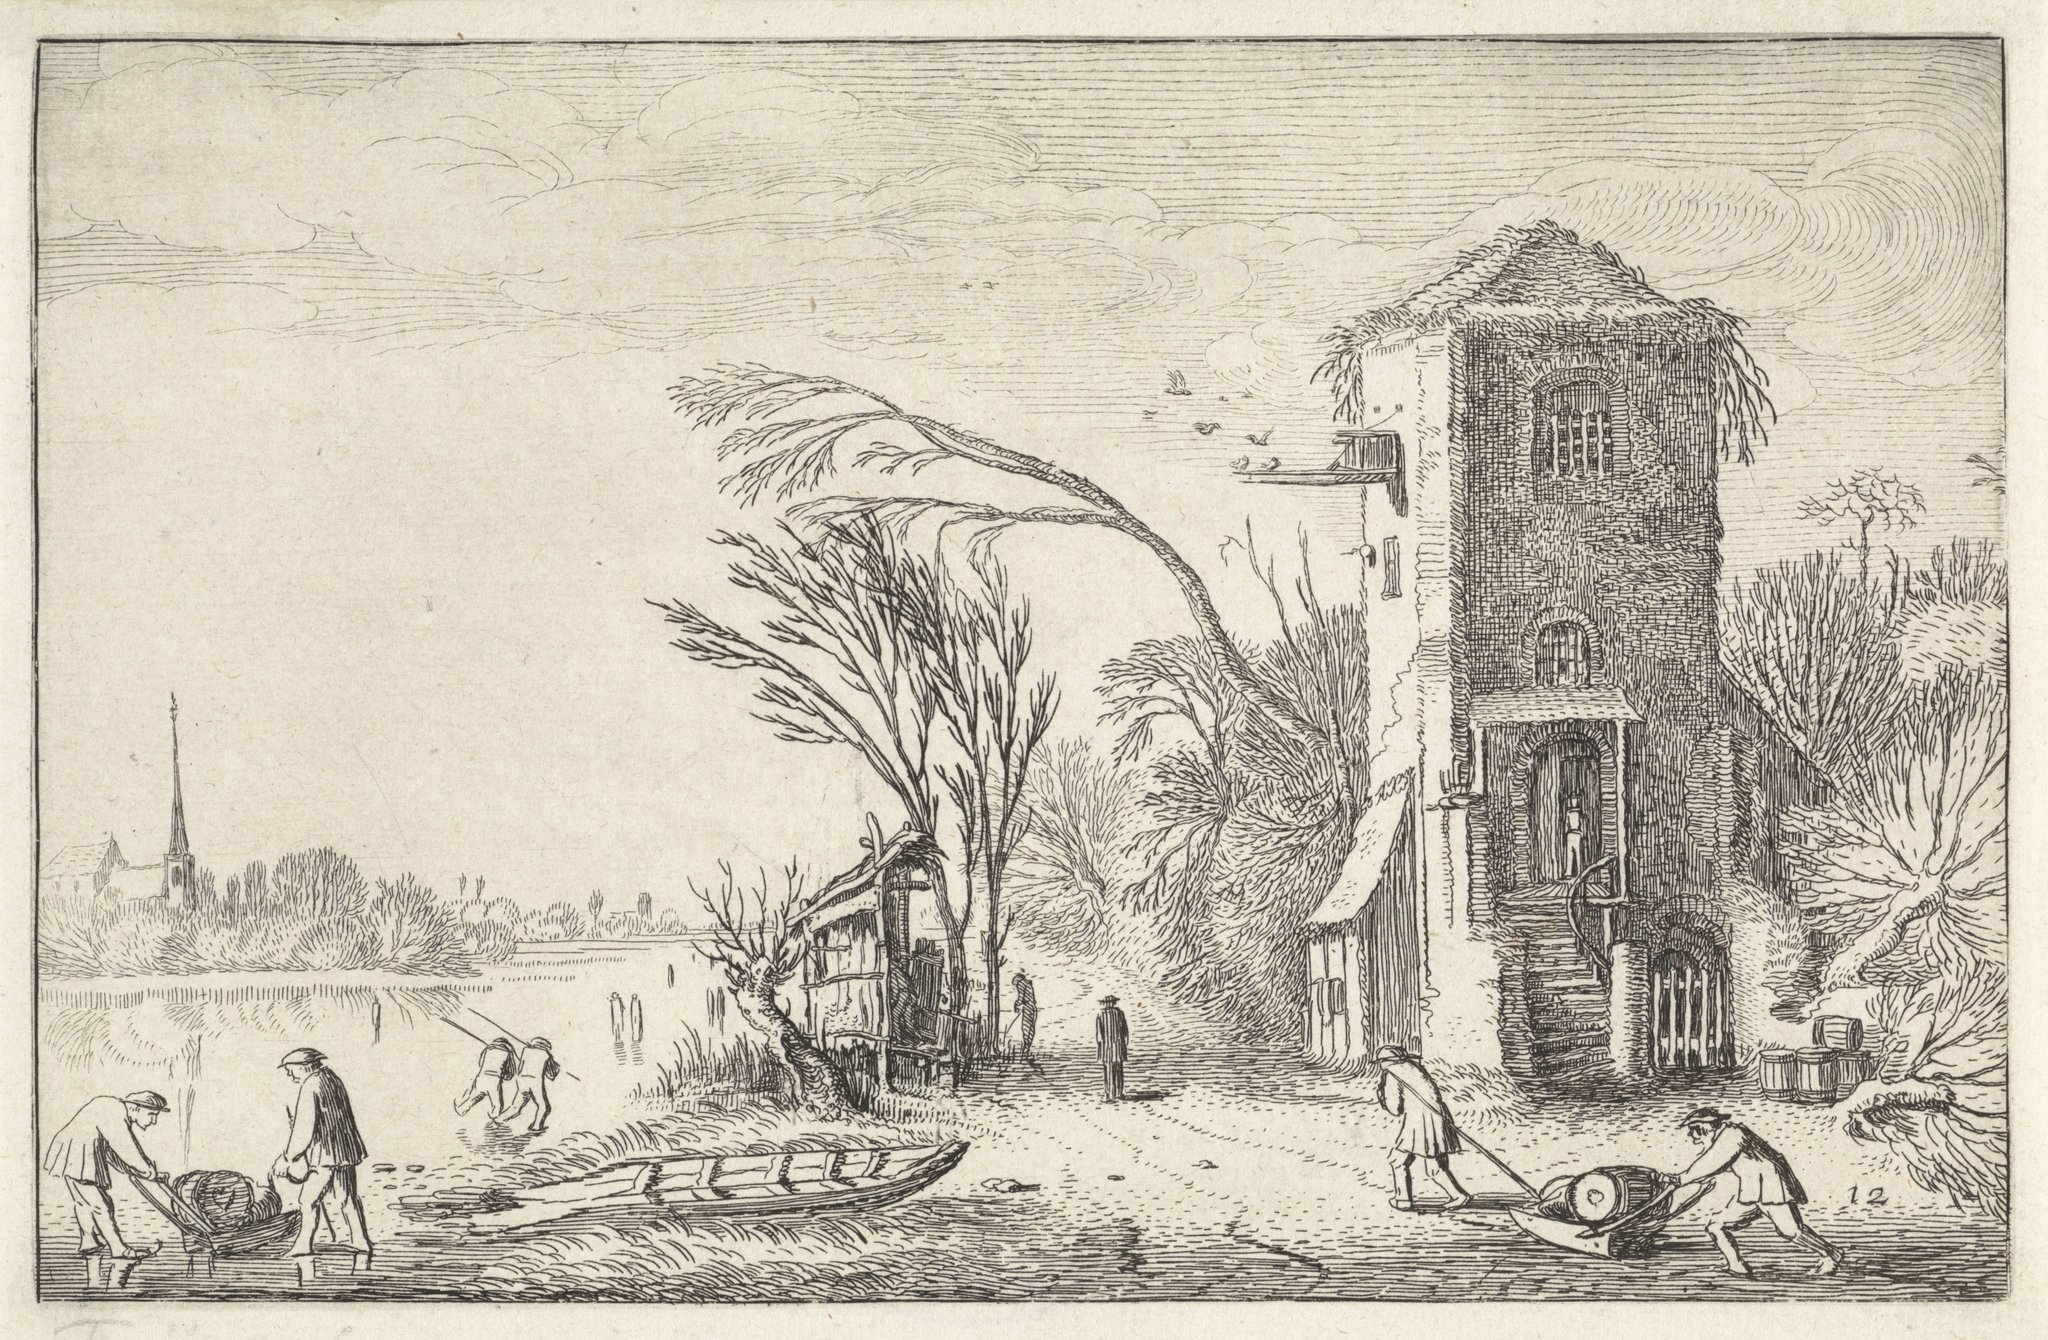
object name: print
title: Landschappen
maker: jan van de velde (ii)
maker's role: draughtsman, painter, print maker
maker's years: 1593-1641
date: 1616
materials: paper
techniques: etching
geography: northern netherlands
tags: landscape with tower or castle, skates (winter sports), small sleigh (winter sports), parts of church exterior and annexes: tower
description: Schaatsers en figuren met sledes met tonnen in een winterlandschap. Links een toren en rechts op de achtergrond een kerktoren. Twaalfde prent van deel twee van een serie van in totaal 52 prenten met landschappen, verdeeld over twee delen van elk 26 prenten.